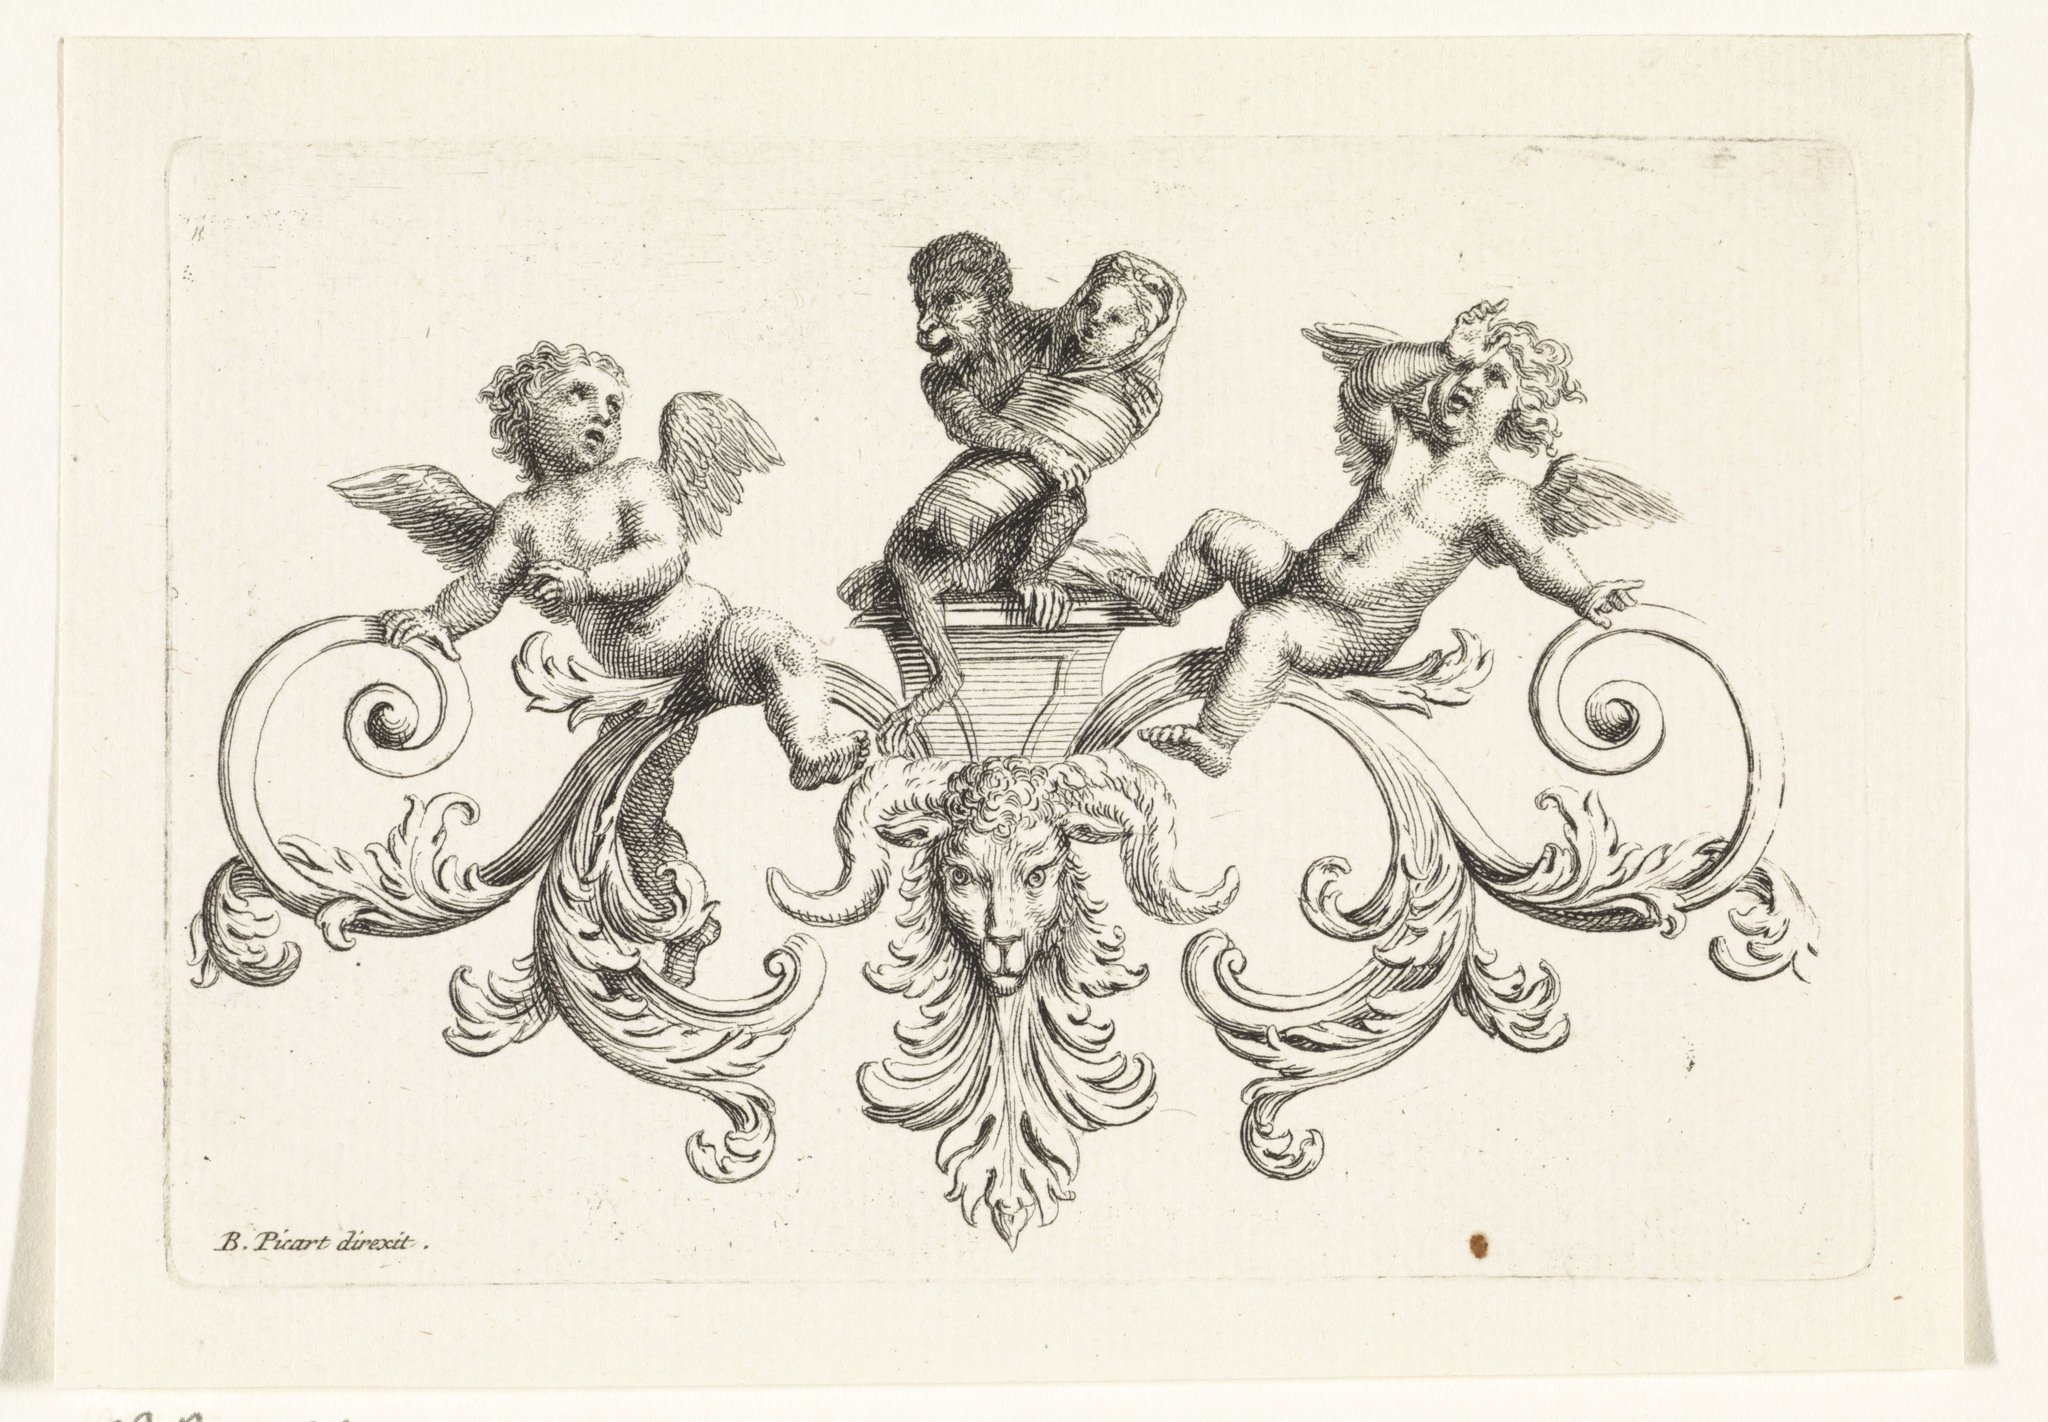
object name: ornament print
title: Aap met een ingebakerd kindje geflankeerd door putti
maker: bernard picart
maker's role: draughtsman, print maker, publisher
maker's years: 1673-1733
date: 1683-1733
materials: paper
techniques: engraving, etching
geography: amsterdam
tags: monkeys, apes, ornament ~ festoon, garland, foliage, tendrils, branches ~ ornament, cupids: 'amores', 'amoretti', 'putti'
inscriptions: collector's mark: Lugt 2233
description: Een aap met een ingebakerd kindje zittend boven bladornamenten. De twee putti schrikken.